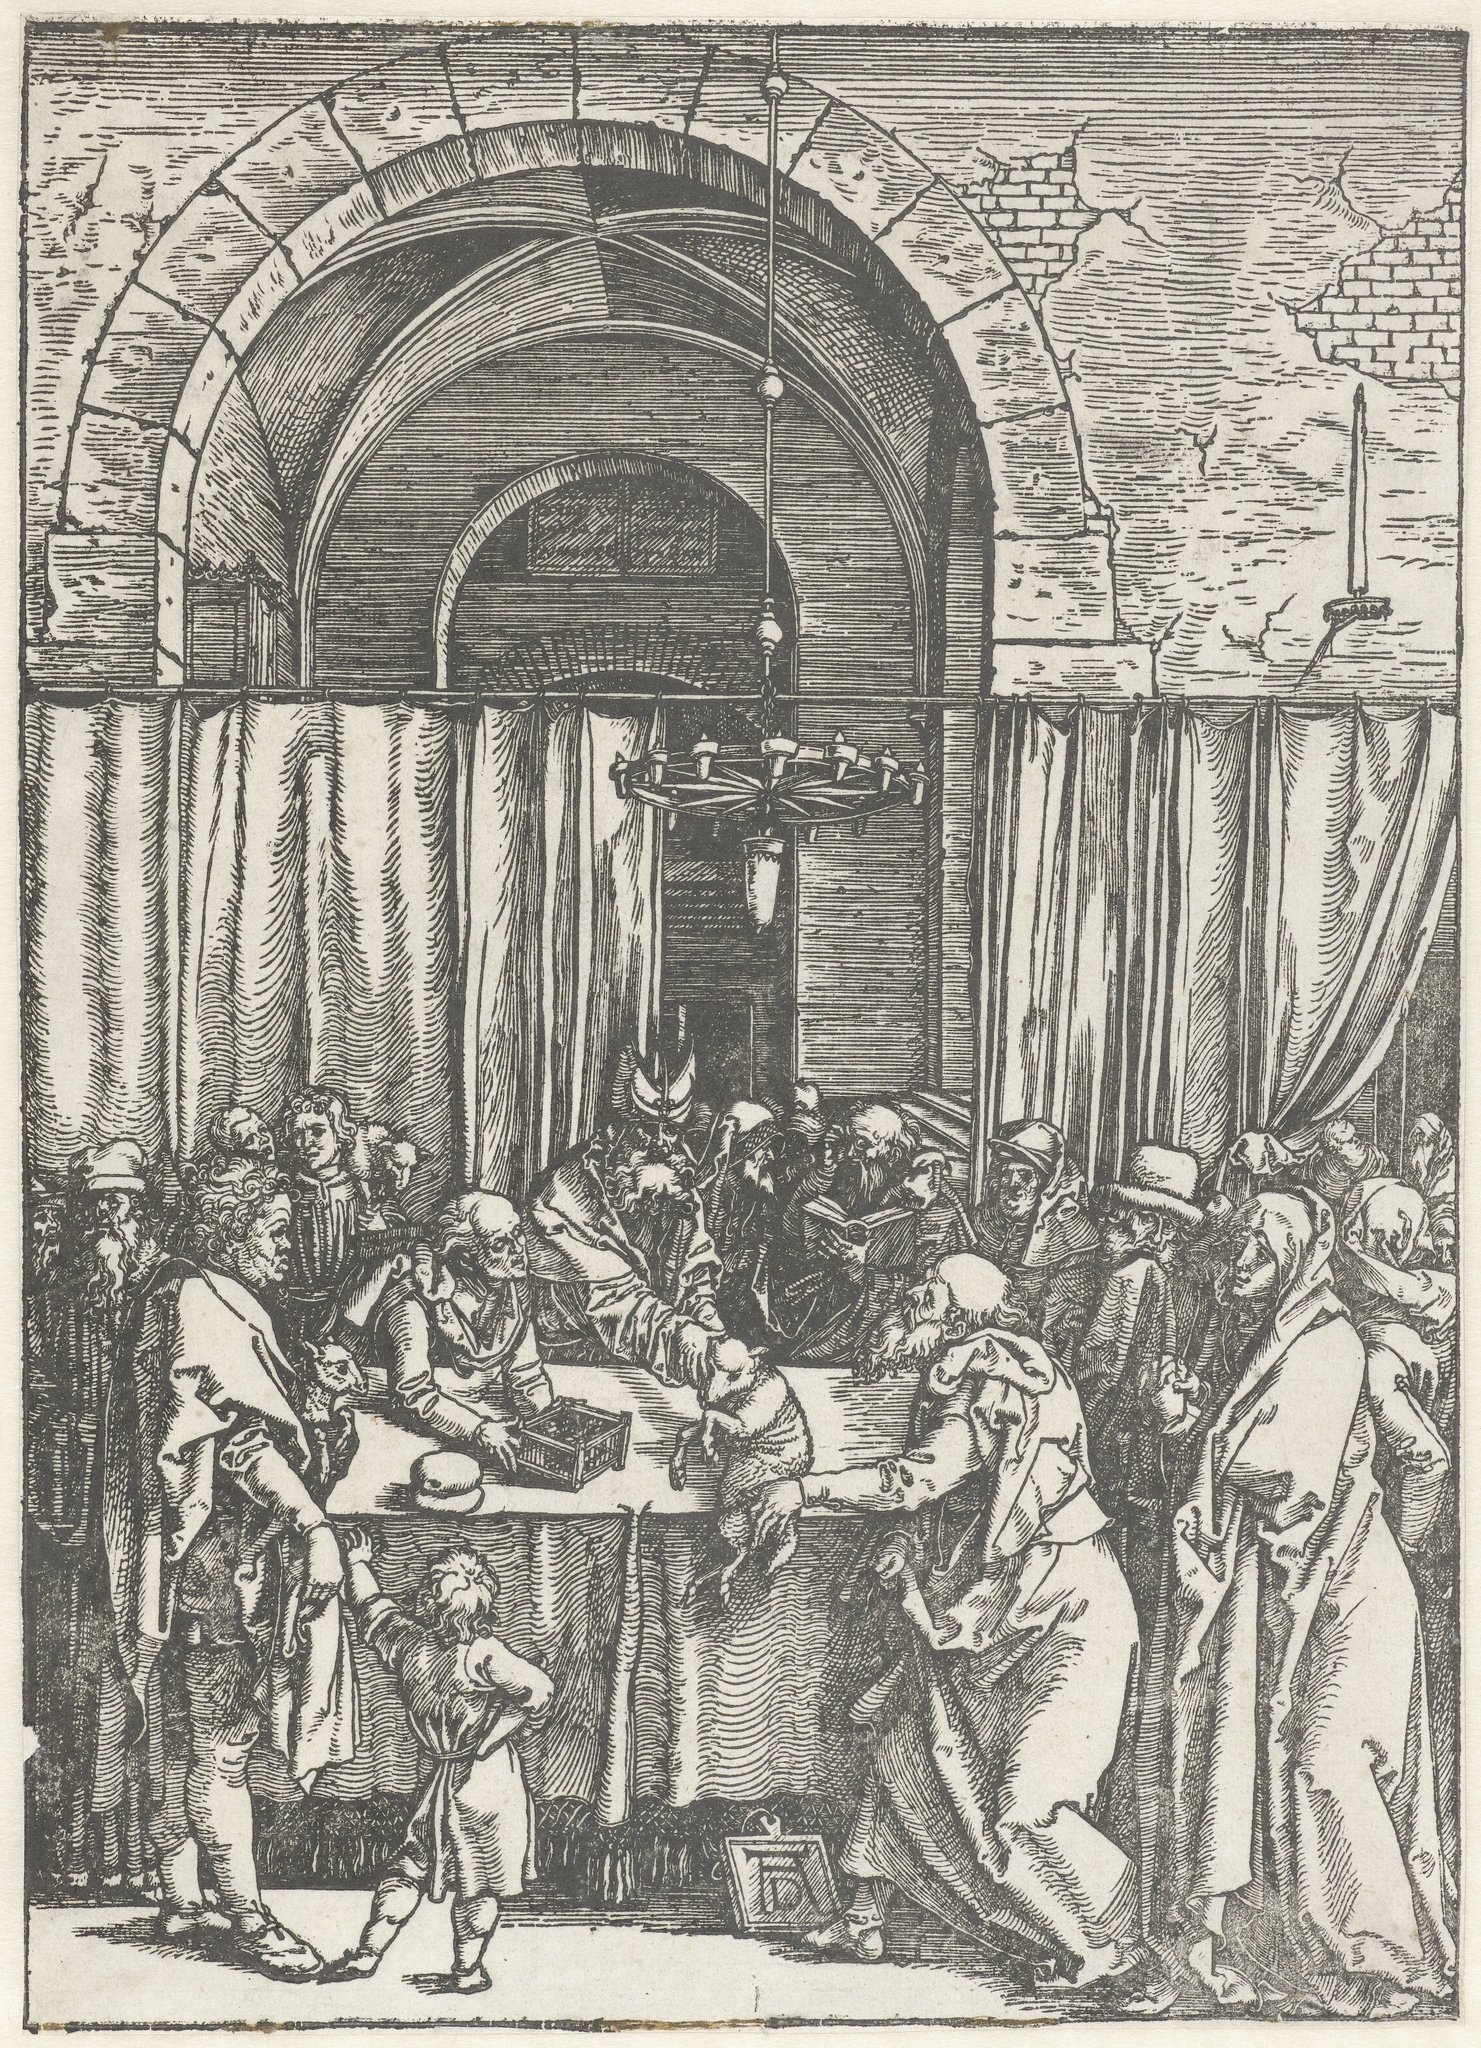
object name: print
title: Het offer van Joachim wordt geweigerd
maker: albrecht dürer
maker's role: draughtsman, painter, print maker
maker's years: 1471-1528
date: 1502-1506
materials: paper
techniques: woodcut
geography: nuremberg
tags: joachim's and anna's sacrifice refused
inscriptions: collector's mark: Lugt 240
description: Joachim staat met Anna bij een tafel, waaromheen veel mensen staan. De hogepriester achter de tafel duwt het lam dat Joachim aanbiedt van de tafel af. Deze prent is onderdeel van een serie van 20 prenten, bestaand uit een titelprent en 19 prenten met scènes uit het leven van Maria.